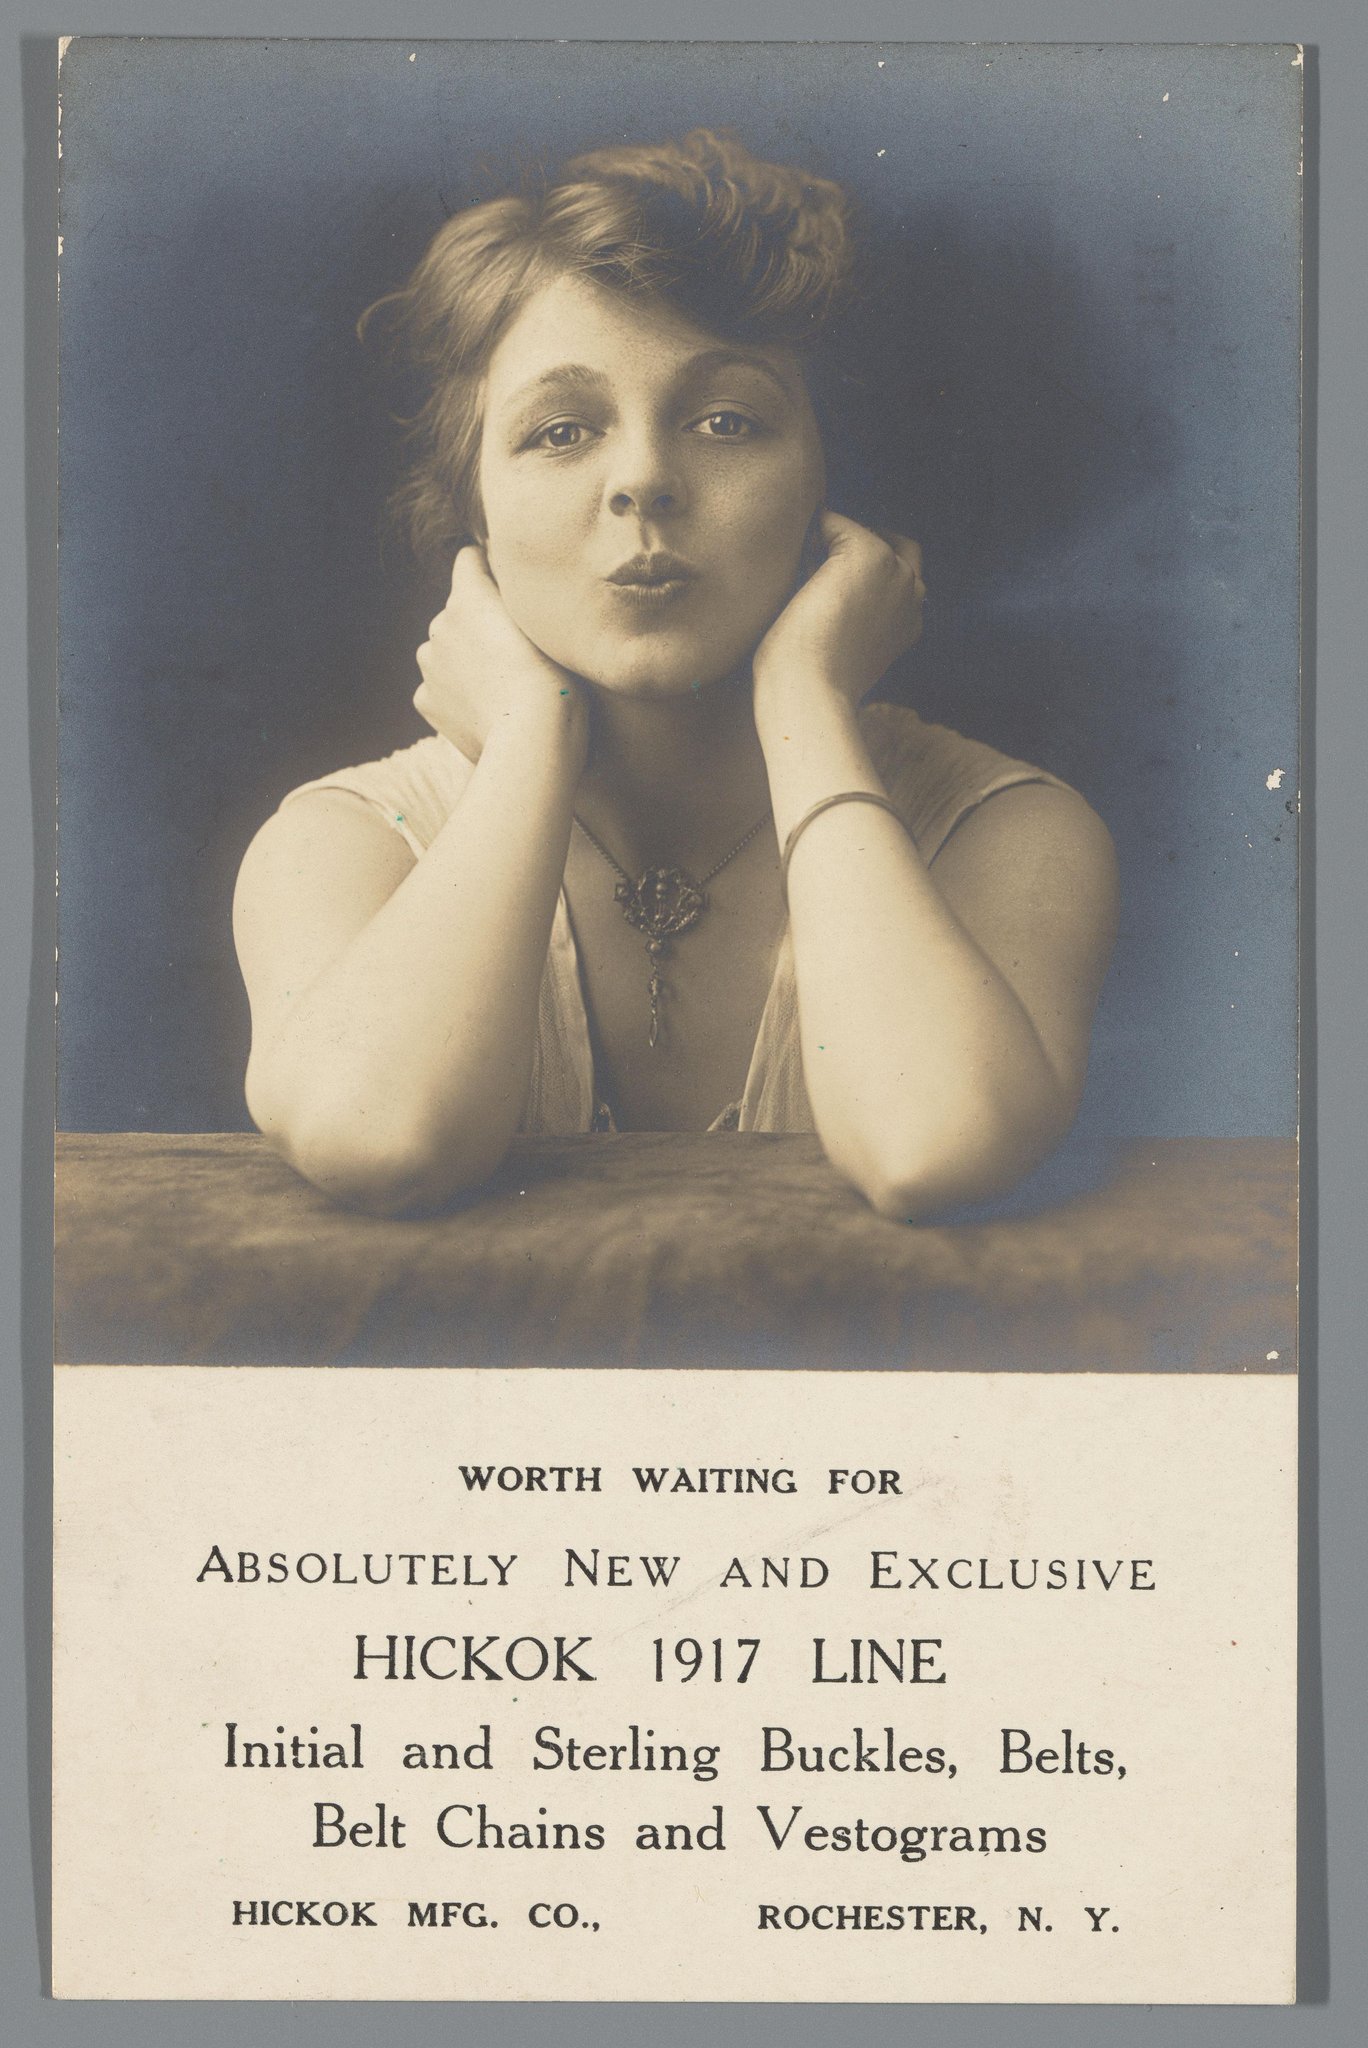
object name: ansichtkaart, prentbriefkaart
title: Portret van vrouw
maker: Anonymous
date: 1917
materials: paper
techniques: gelatin silver print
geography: united states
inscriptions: inscription: ‘POST CARD / Our Mr. [.opengelaten] / WILL CALL ABOUT [opengelaten] / HICKOK MFG. CO. / ROCHESTER, N. Y.’, inscription: ‘WORYTH WAITING FOR / ABSOLUTELY NEW ANS EXCLUSIVE / HICKOK 1917 LINE / Initial and Sterling Buckles, Belts, / Belt Chains and Vestograms / HICKOK MFG. CO. ROCHESTER, N. Y.’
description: Reclamefoto voor Hicock riemen, gespen en andere kledingaccessoires voor mannen